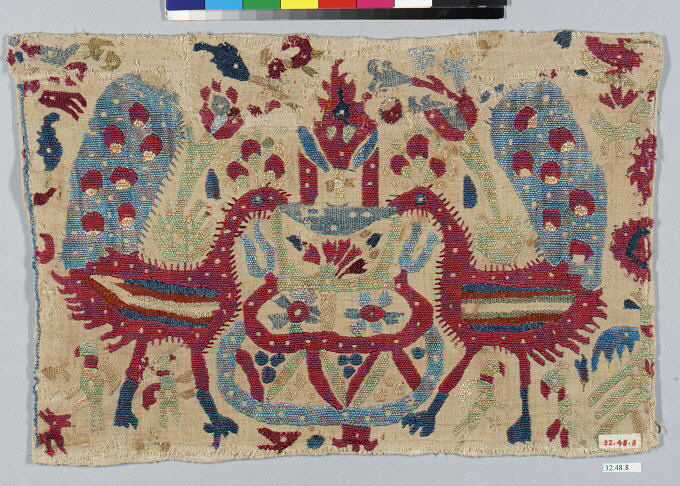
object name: fragment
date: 1701-1800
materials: cotton, silk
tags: peacocks